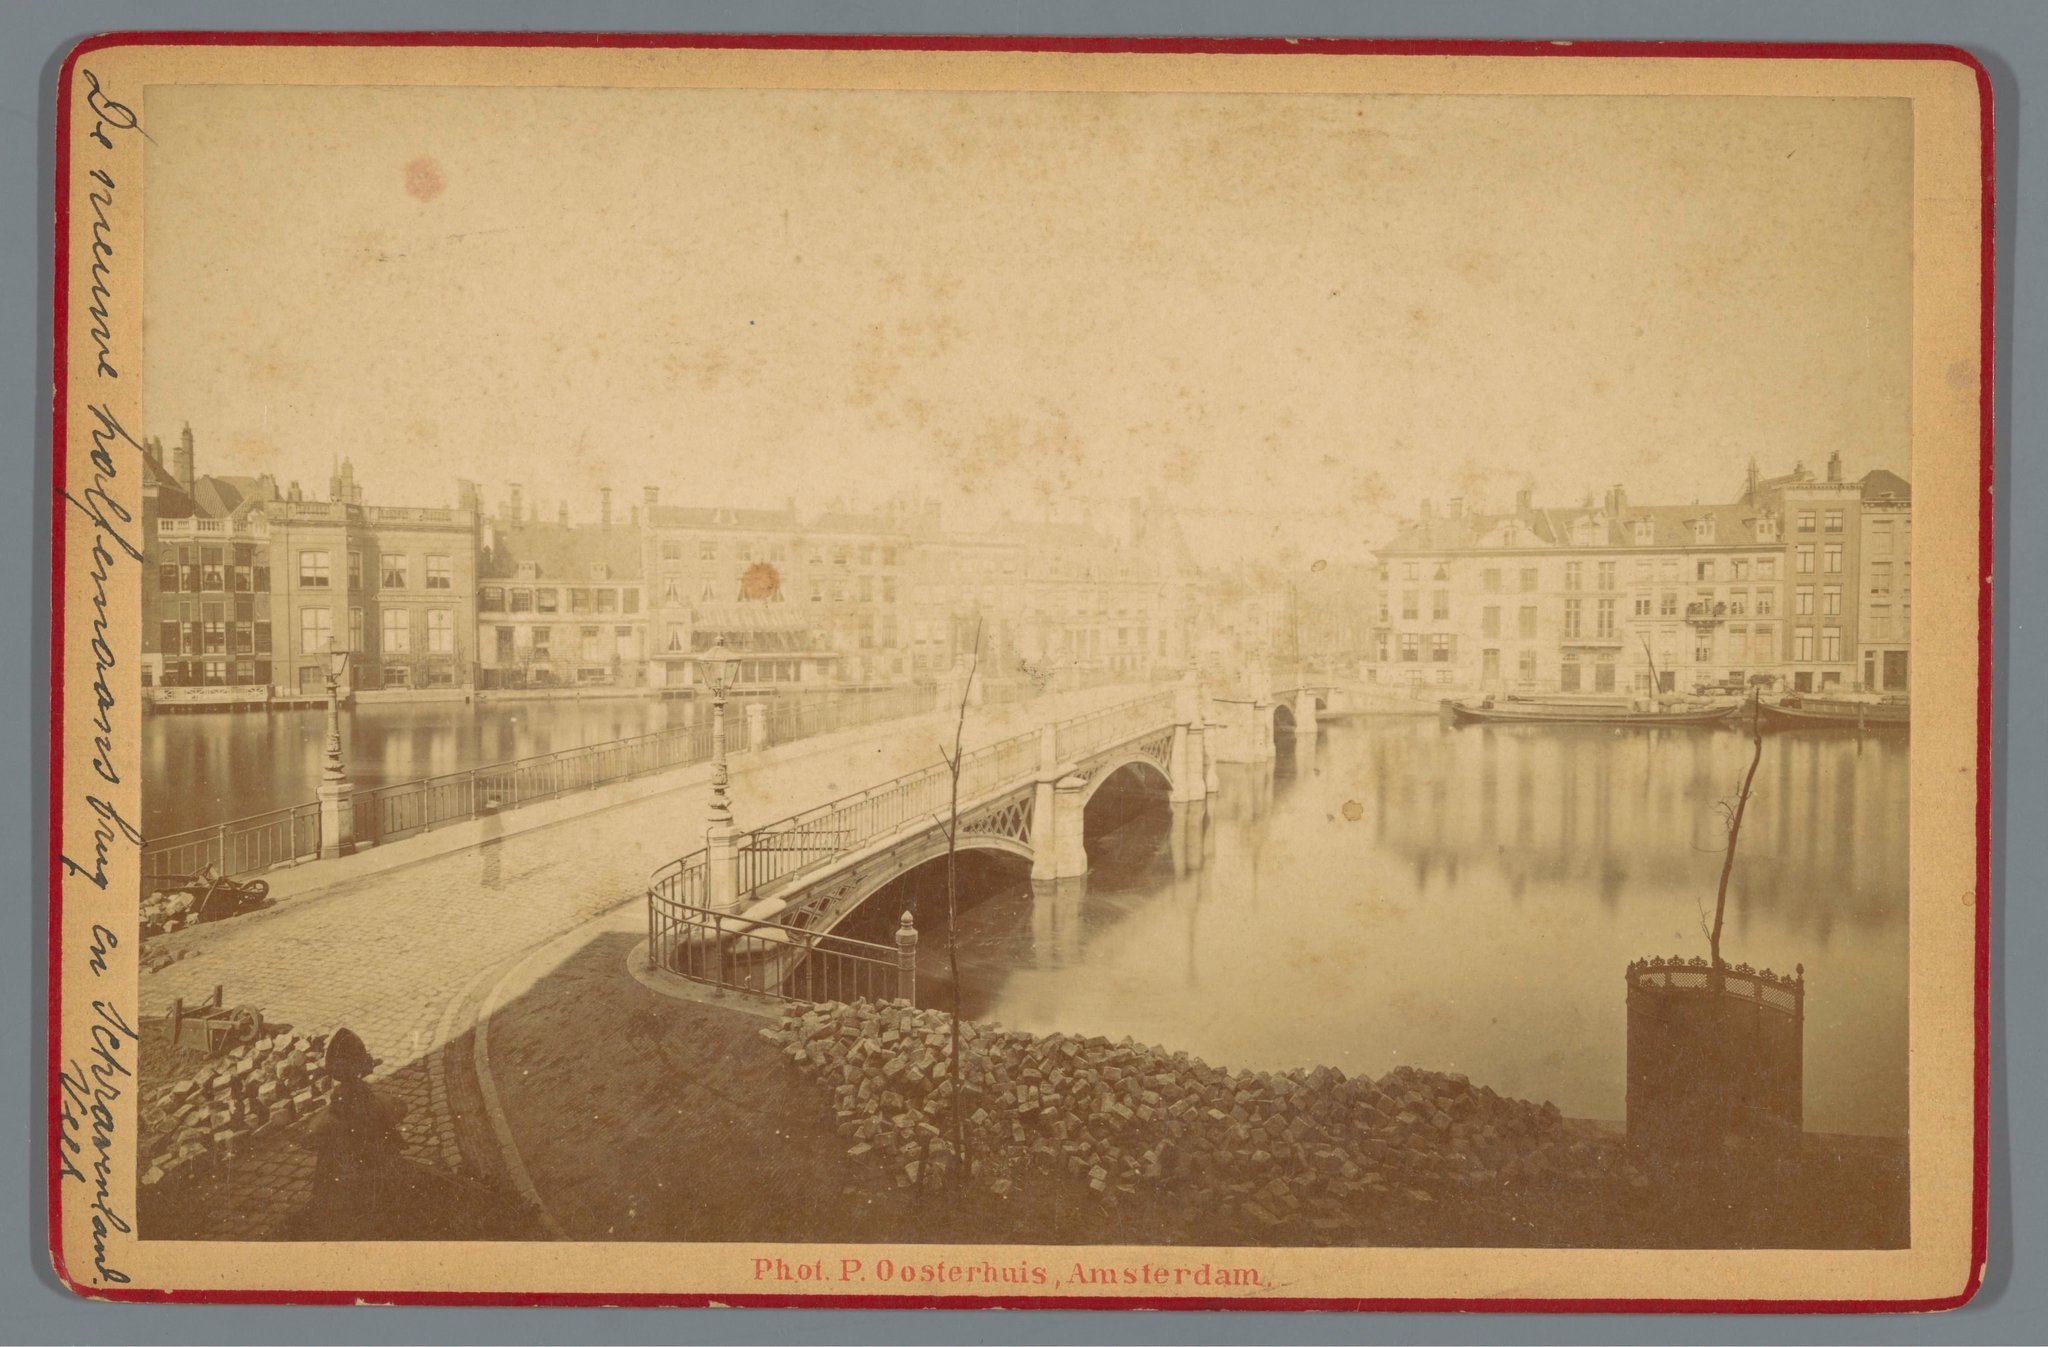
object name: cabinet photograph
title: De nieuwe Halvemaansbrug en Schravenland veer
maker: pieter oosterhuis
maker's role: draughtsman, print maker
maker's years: 1816-1885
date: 1863-1865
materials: cardboard, paper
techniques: albumen print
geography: amsterdam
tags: bridge in city across river, canal, etc.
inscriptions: inscription: ‘no. 121./ Halvemaansbrug.’, inscription: ‘Phot. P. Oosterhuis, Amsterdam.’